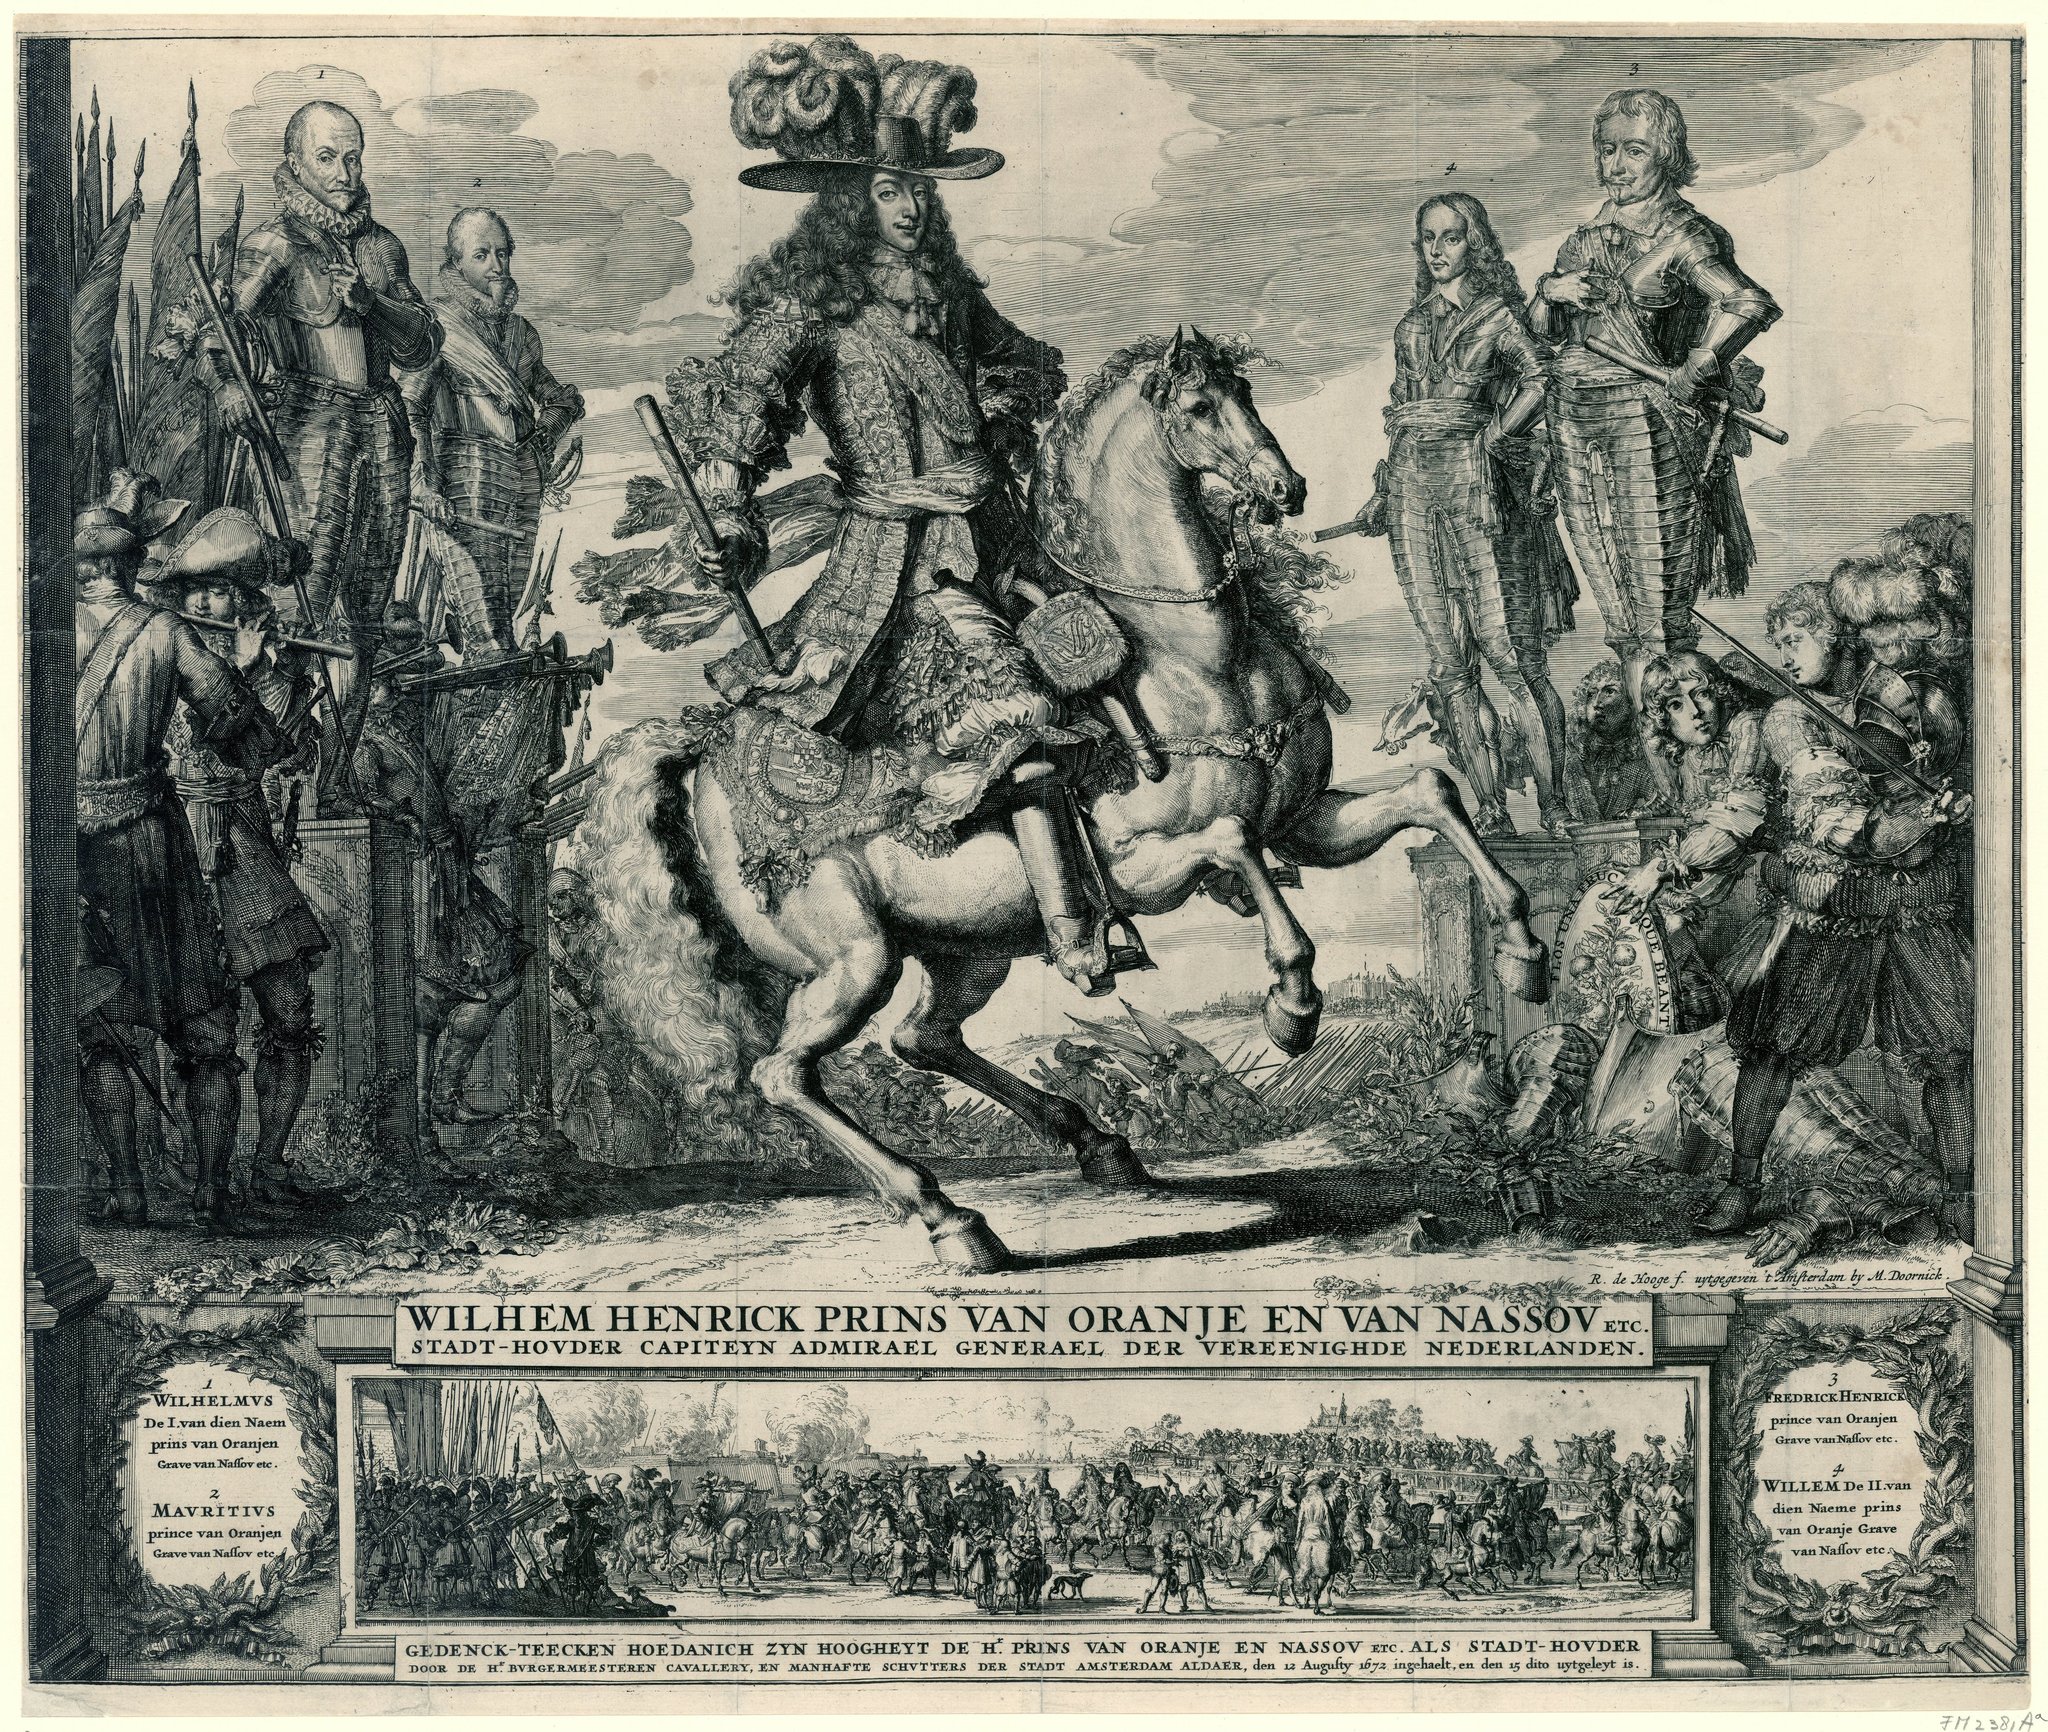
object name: print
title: Ruiterportret van Willem III als stadhouder en kapitein-generaal van de verenigde Nederlanden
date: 1672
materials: paper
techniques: engraving, etching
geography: amsterdam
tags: william iii (prince of orange and king of england, scotland, and ireland), the hague, frederick henry (prince of orange), william ii (prince of orange), delft, william i (prince of orange), maurice (prince of orange), knighthood order (garter) - insignia of a knighthood order, e.g.: badge, chain, amsterdam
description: Ruiterportret van Willem III als stadhouder en kapitein-generaal van de verenigde Nederlanden, met hoed. De prins is afgebeeld tussen standbeelden van zijn voorgangers genummerd 1-4. Links: Willem van Oranje en prins Maurits. Rechts: Frederik Hendrik en Willem II. Onderaan een voorstelling van de uittocht van Willem III te Amsterdam op 15 augustus 1672.